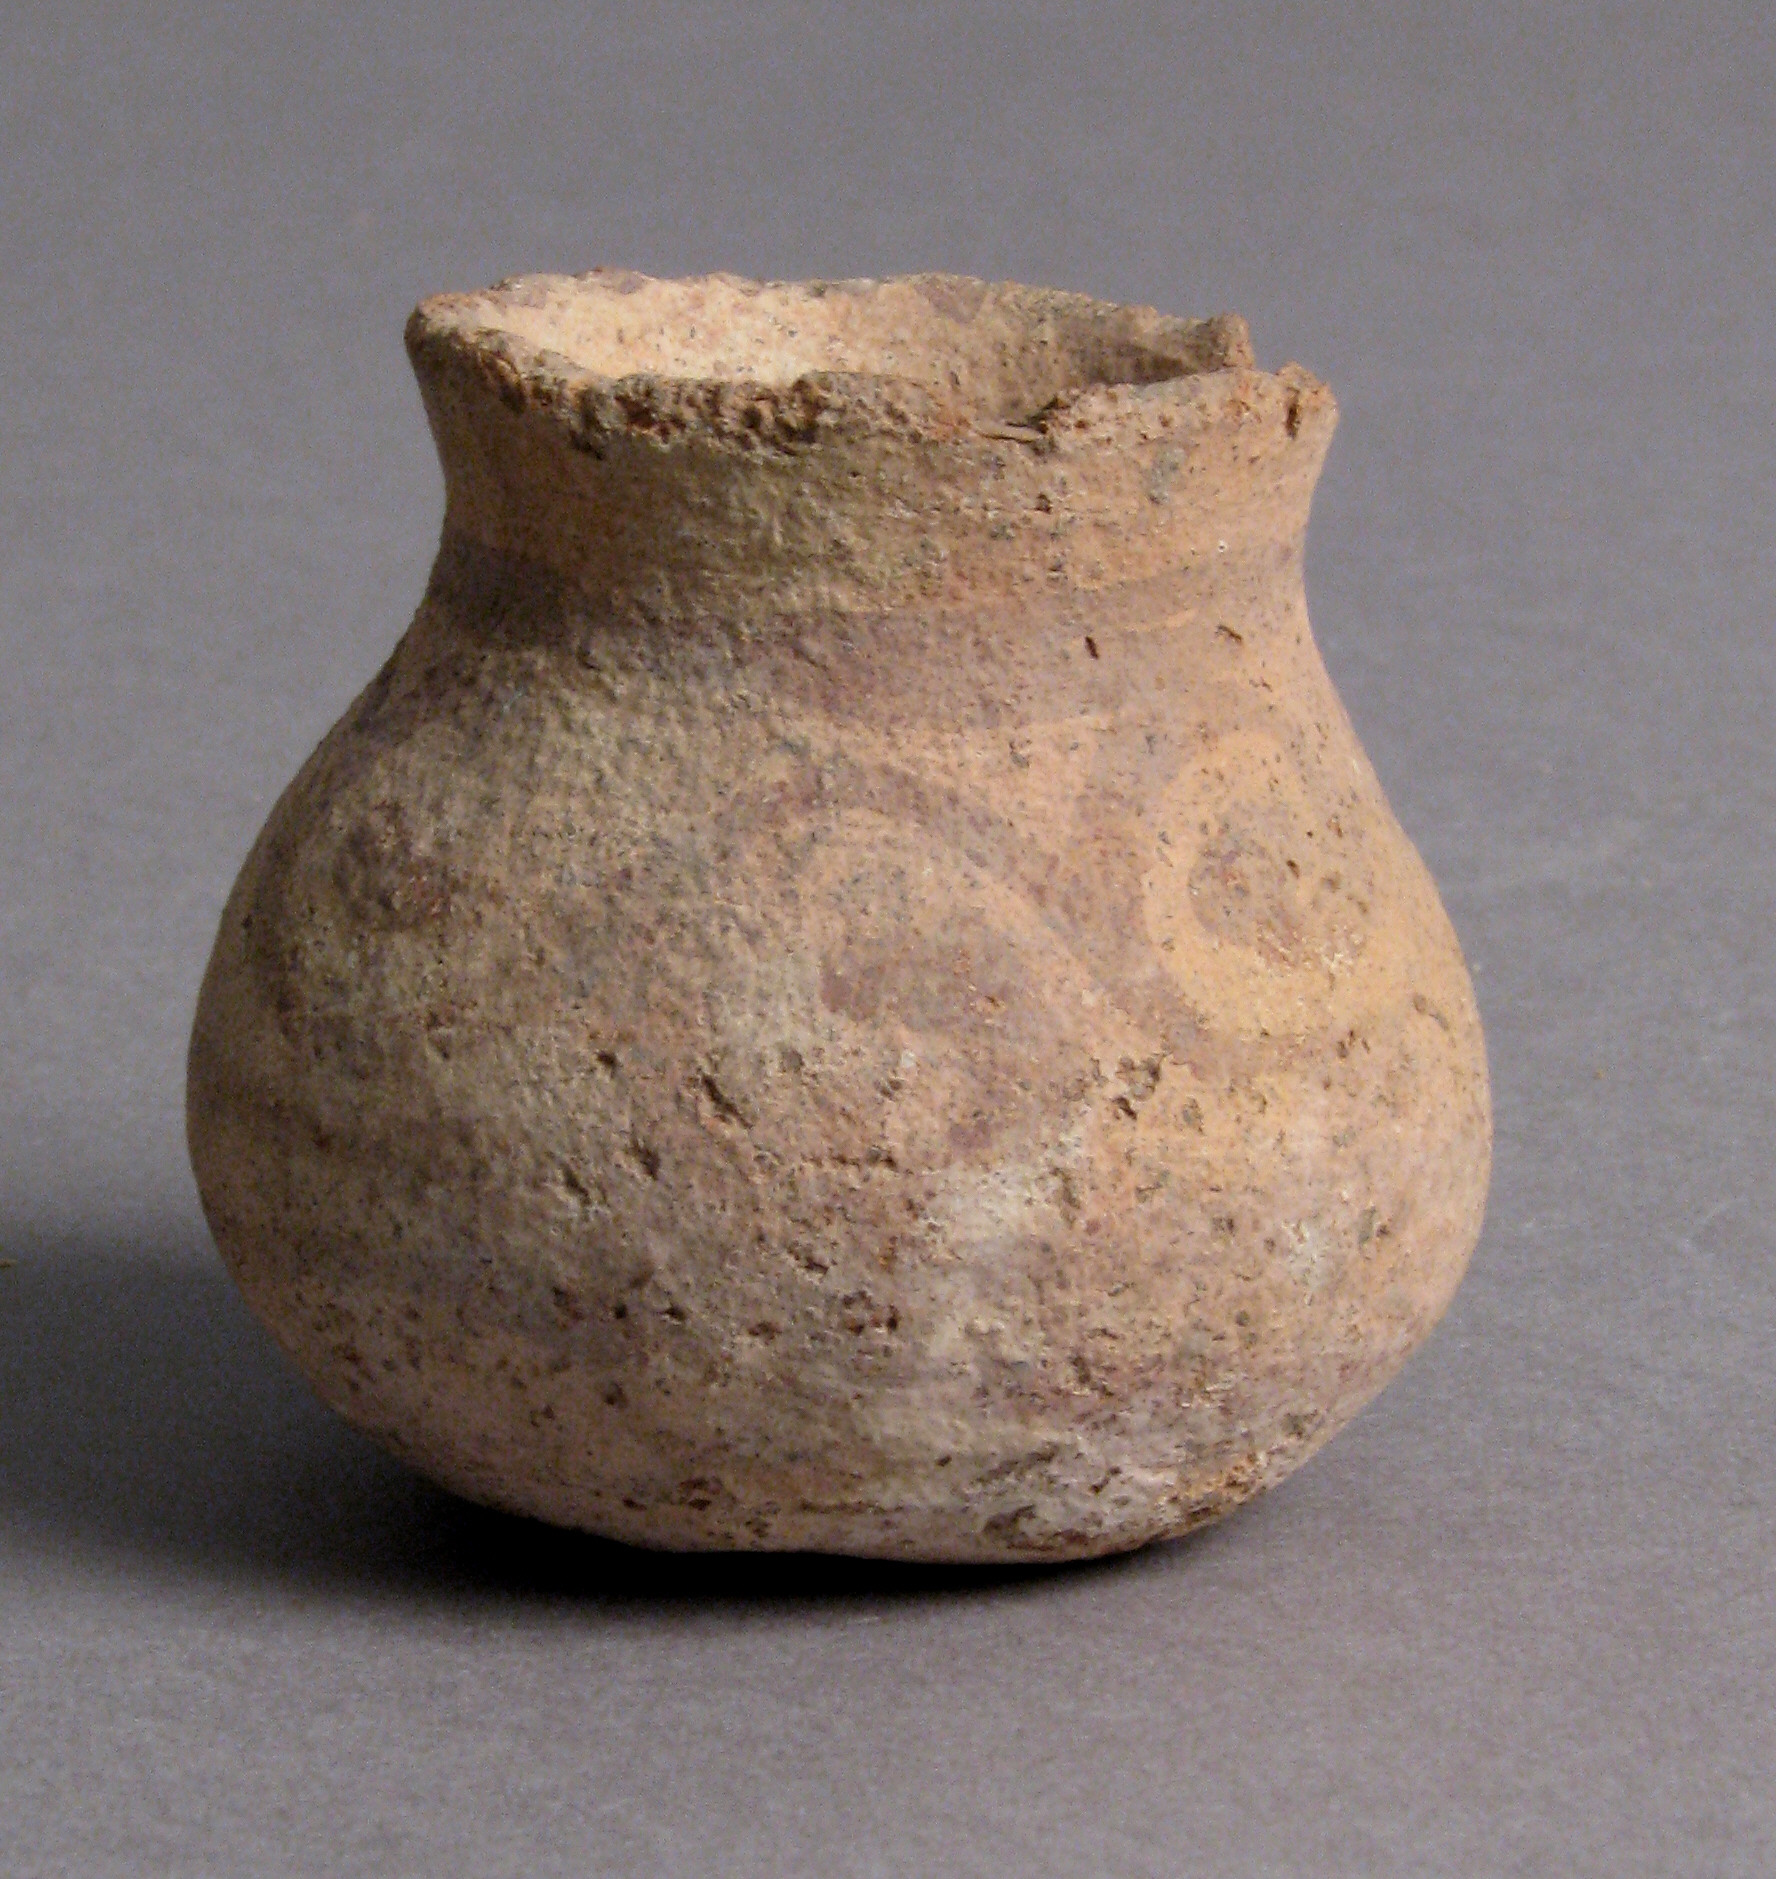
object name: pot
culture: coptic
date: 301-700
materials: earthenware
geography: egypt